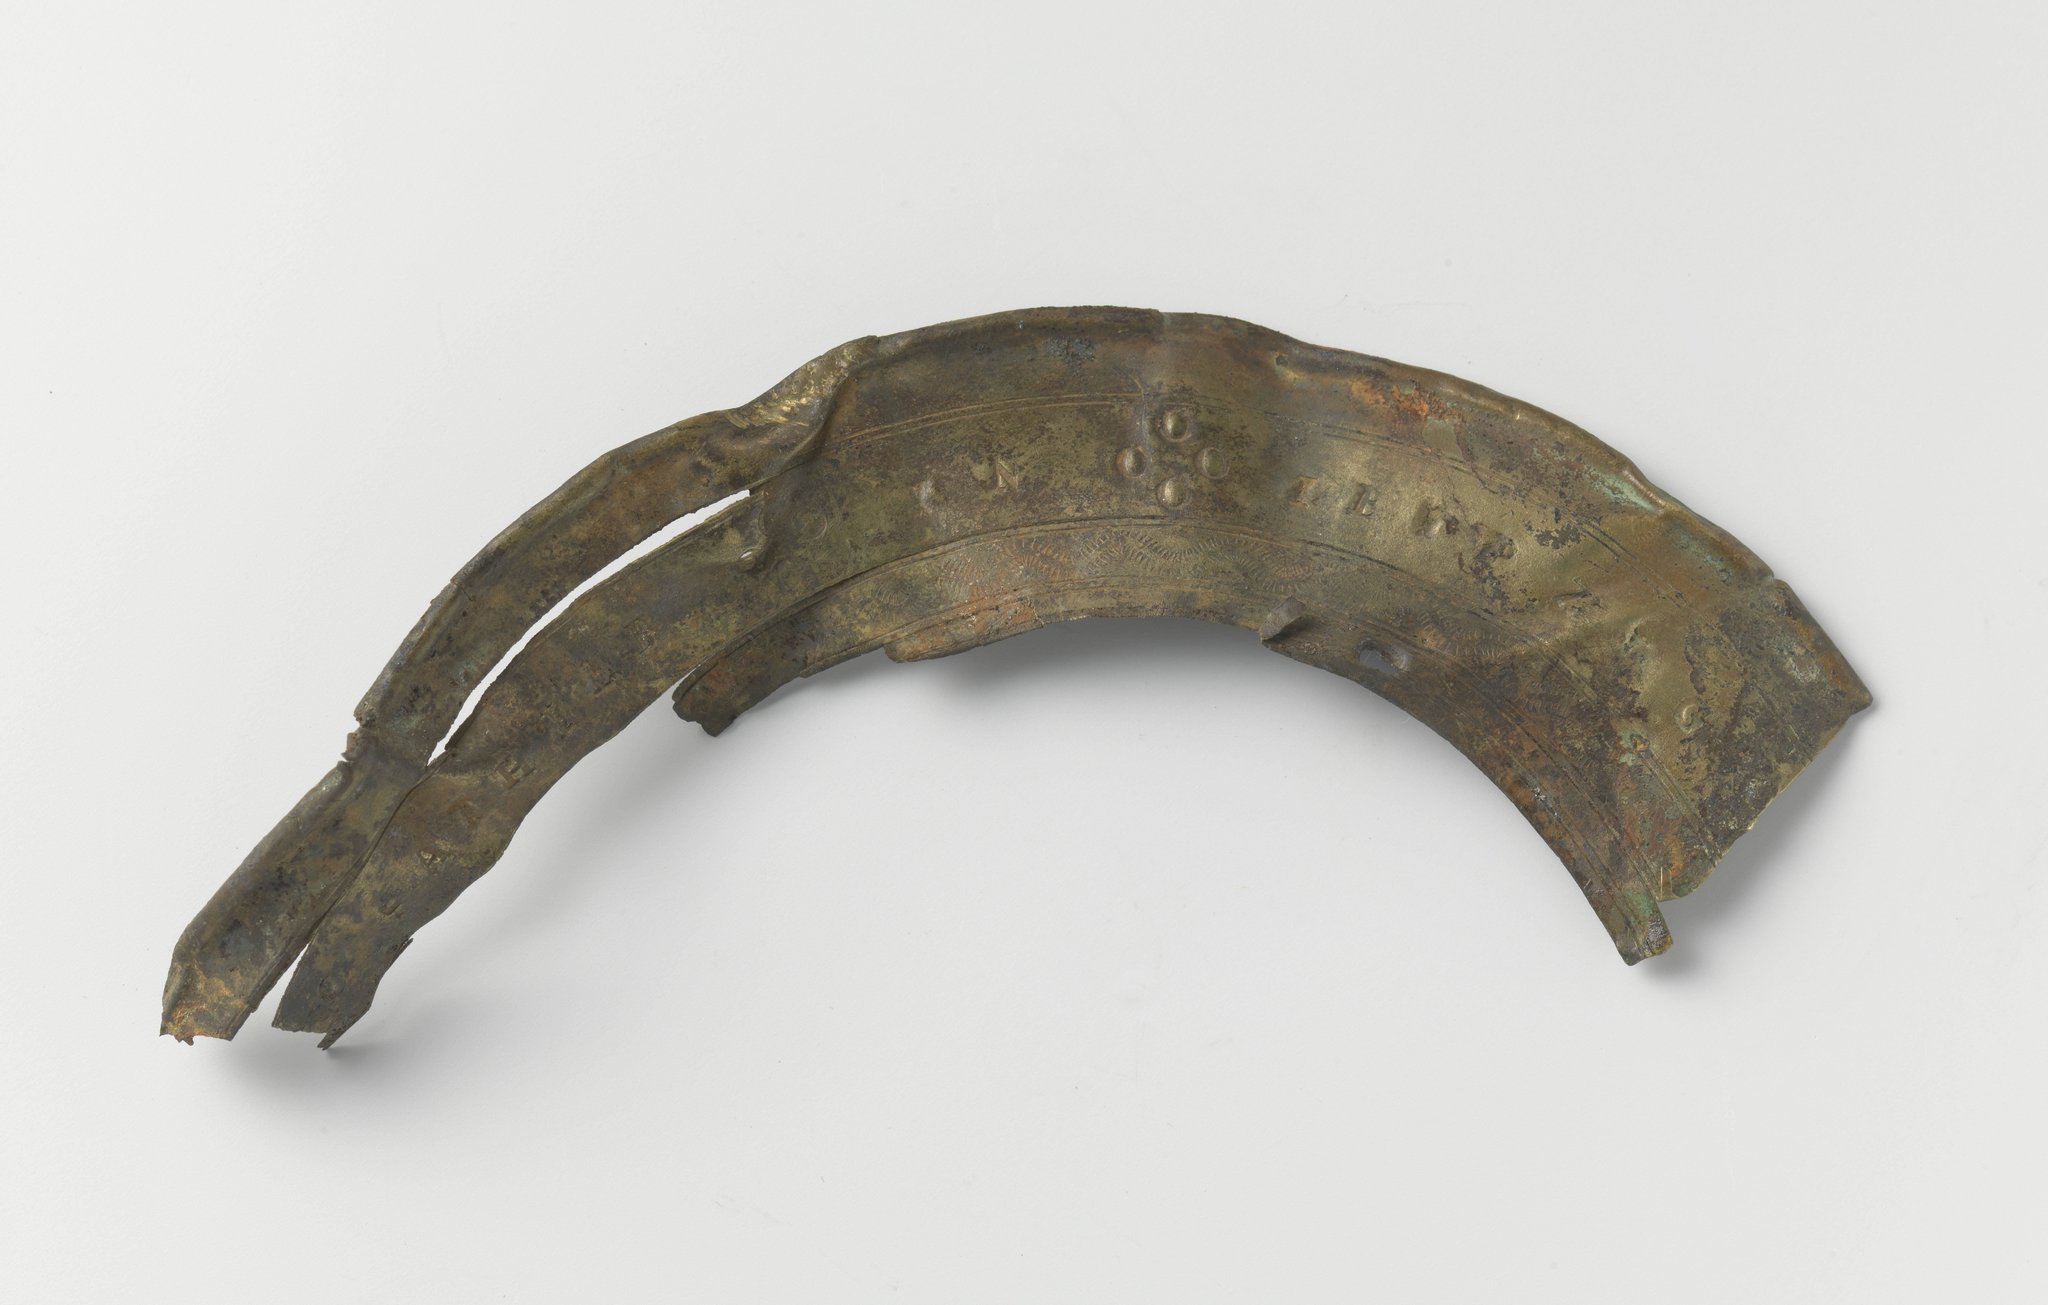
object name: wind instrument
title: Brass instrument fragment from the wreck of the East Indiaman Hollandiaship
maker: Anonymous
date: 1700-1743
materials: copper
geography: leipzig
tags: verenigde oostindische compagnie, hollandia (schip), annet